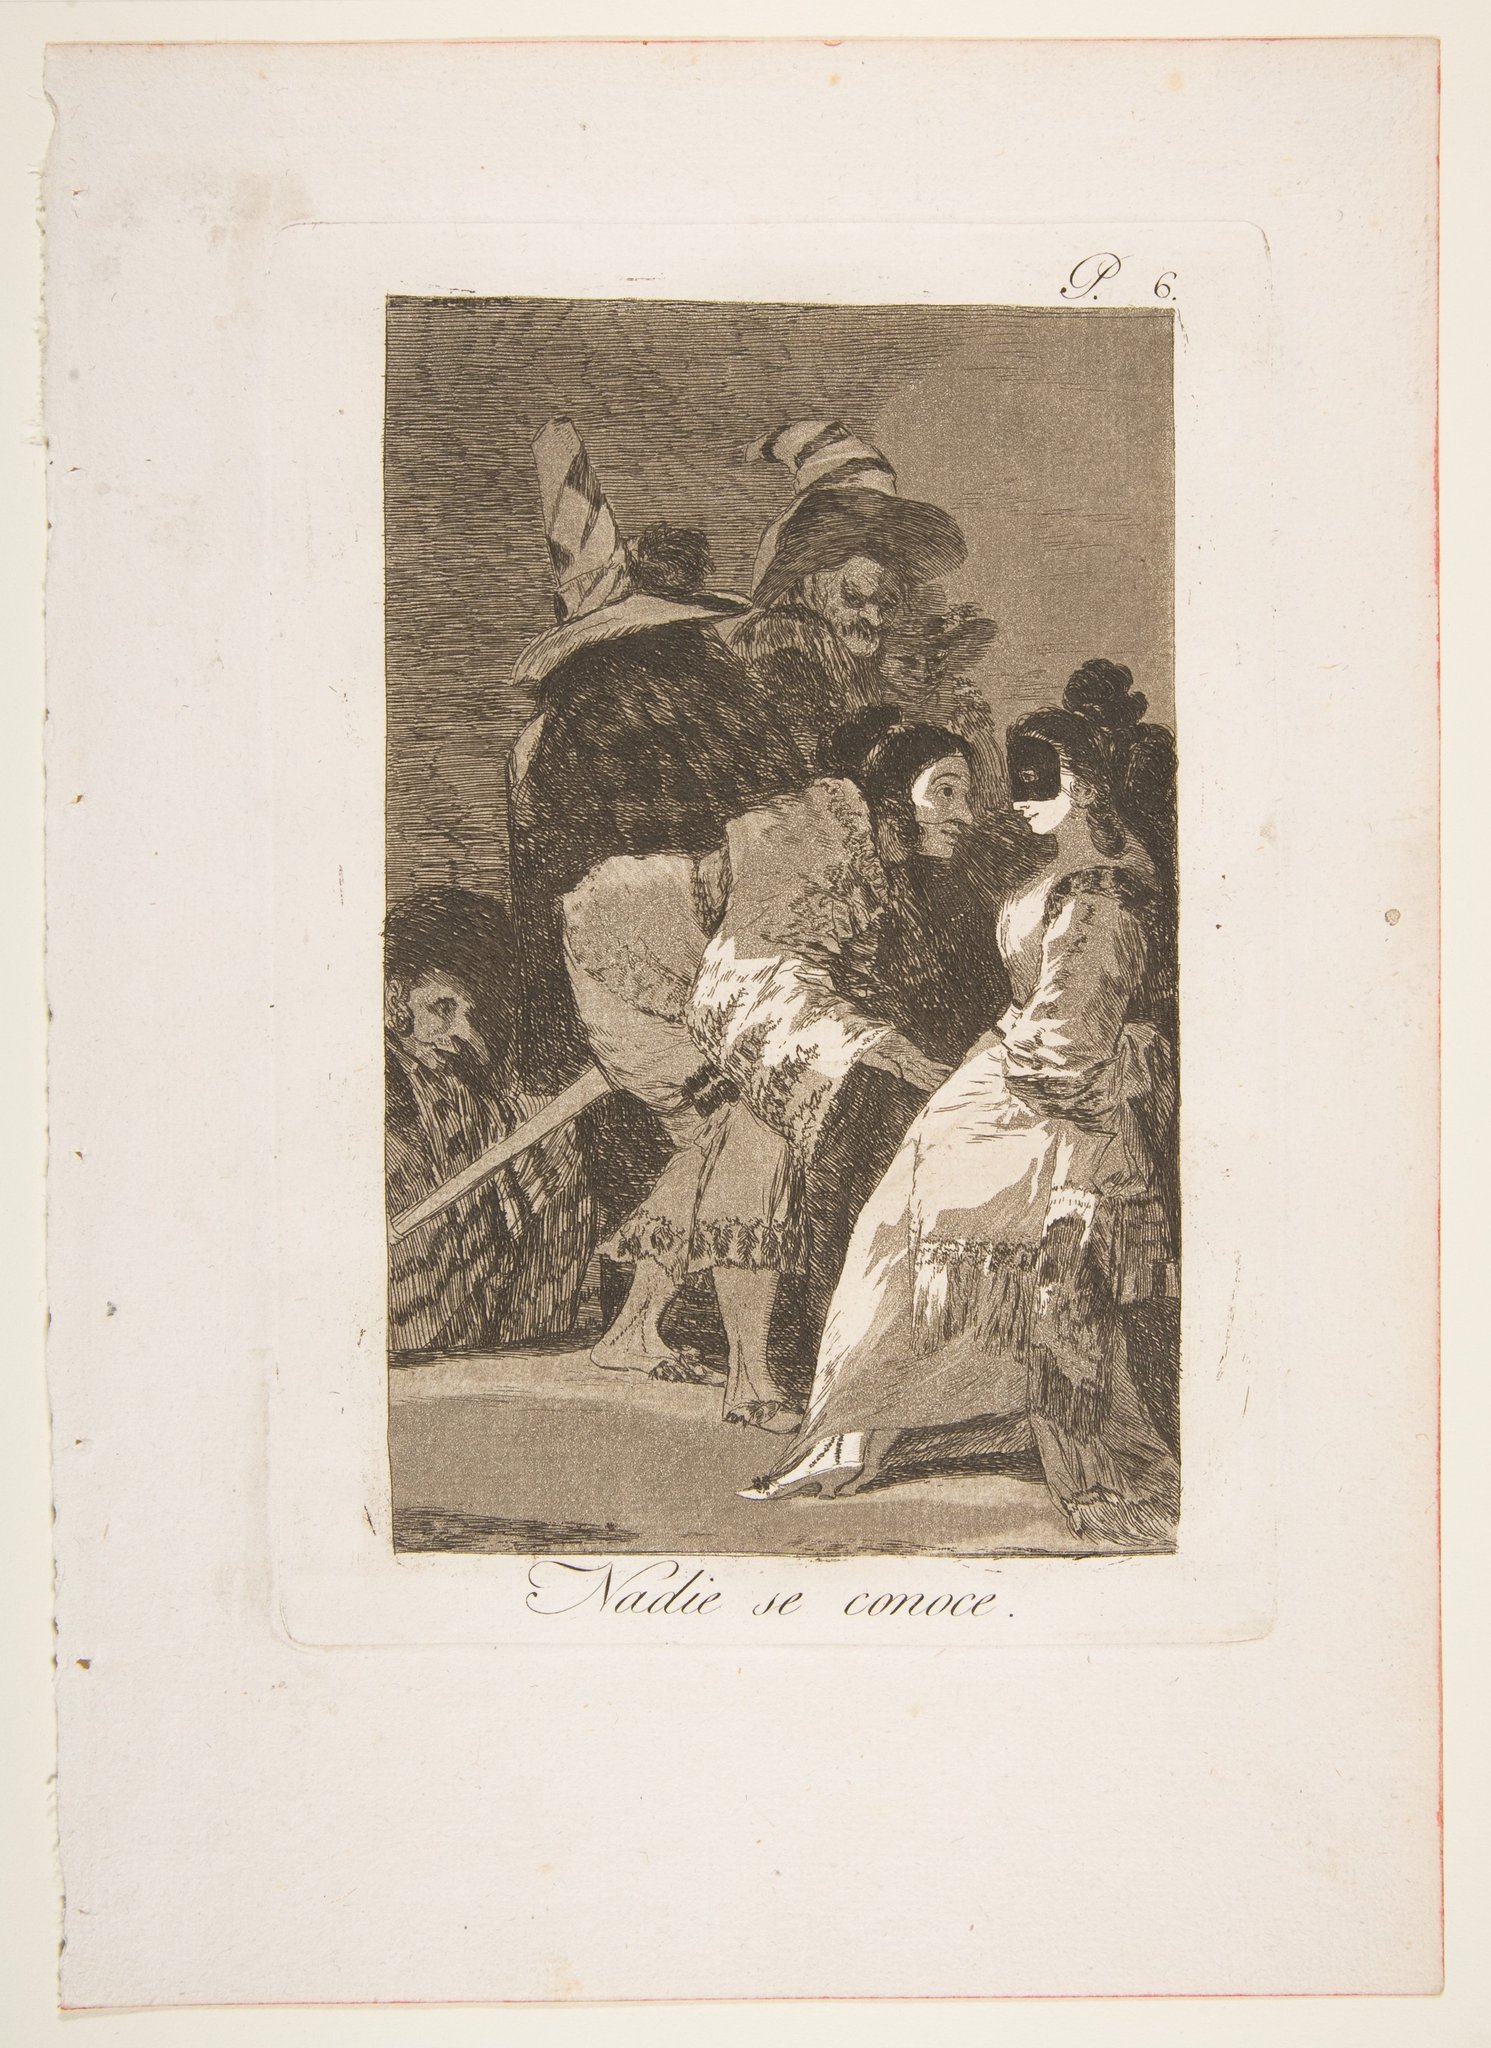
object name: print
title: Plate 6 from "Los Caprichos": Nobody knows himself (Nadie se conoce)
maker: goya (francisco de goya y lucientes)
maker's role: artist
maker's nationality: spanish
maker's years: 1746-1828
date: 1799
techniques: aquatint, burnishing, etching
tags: men,women